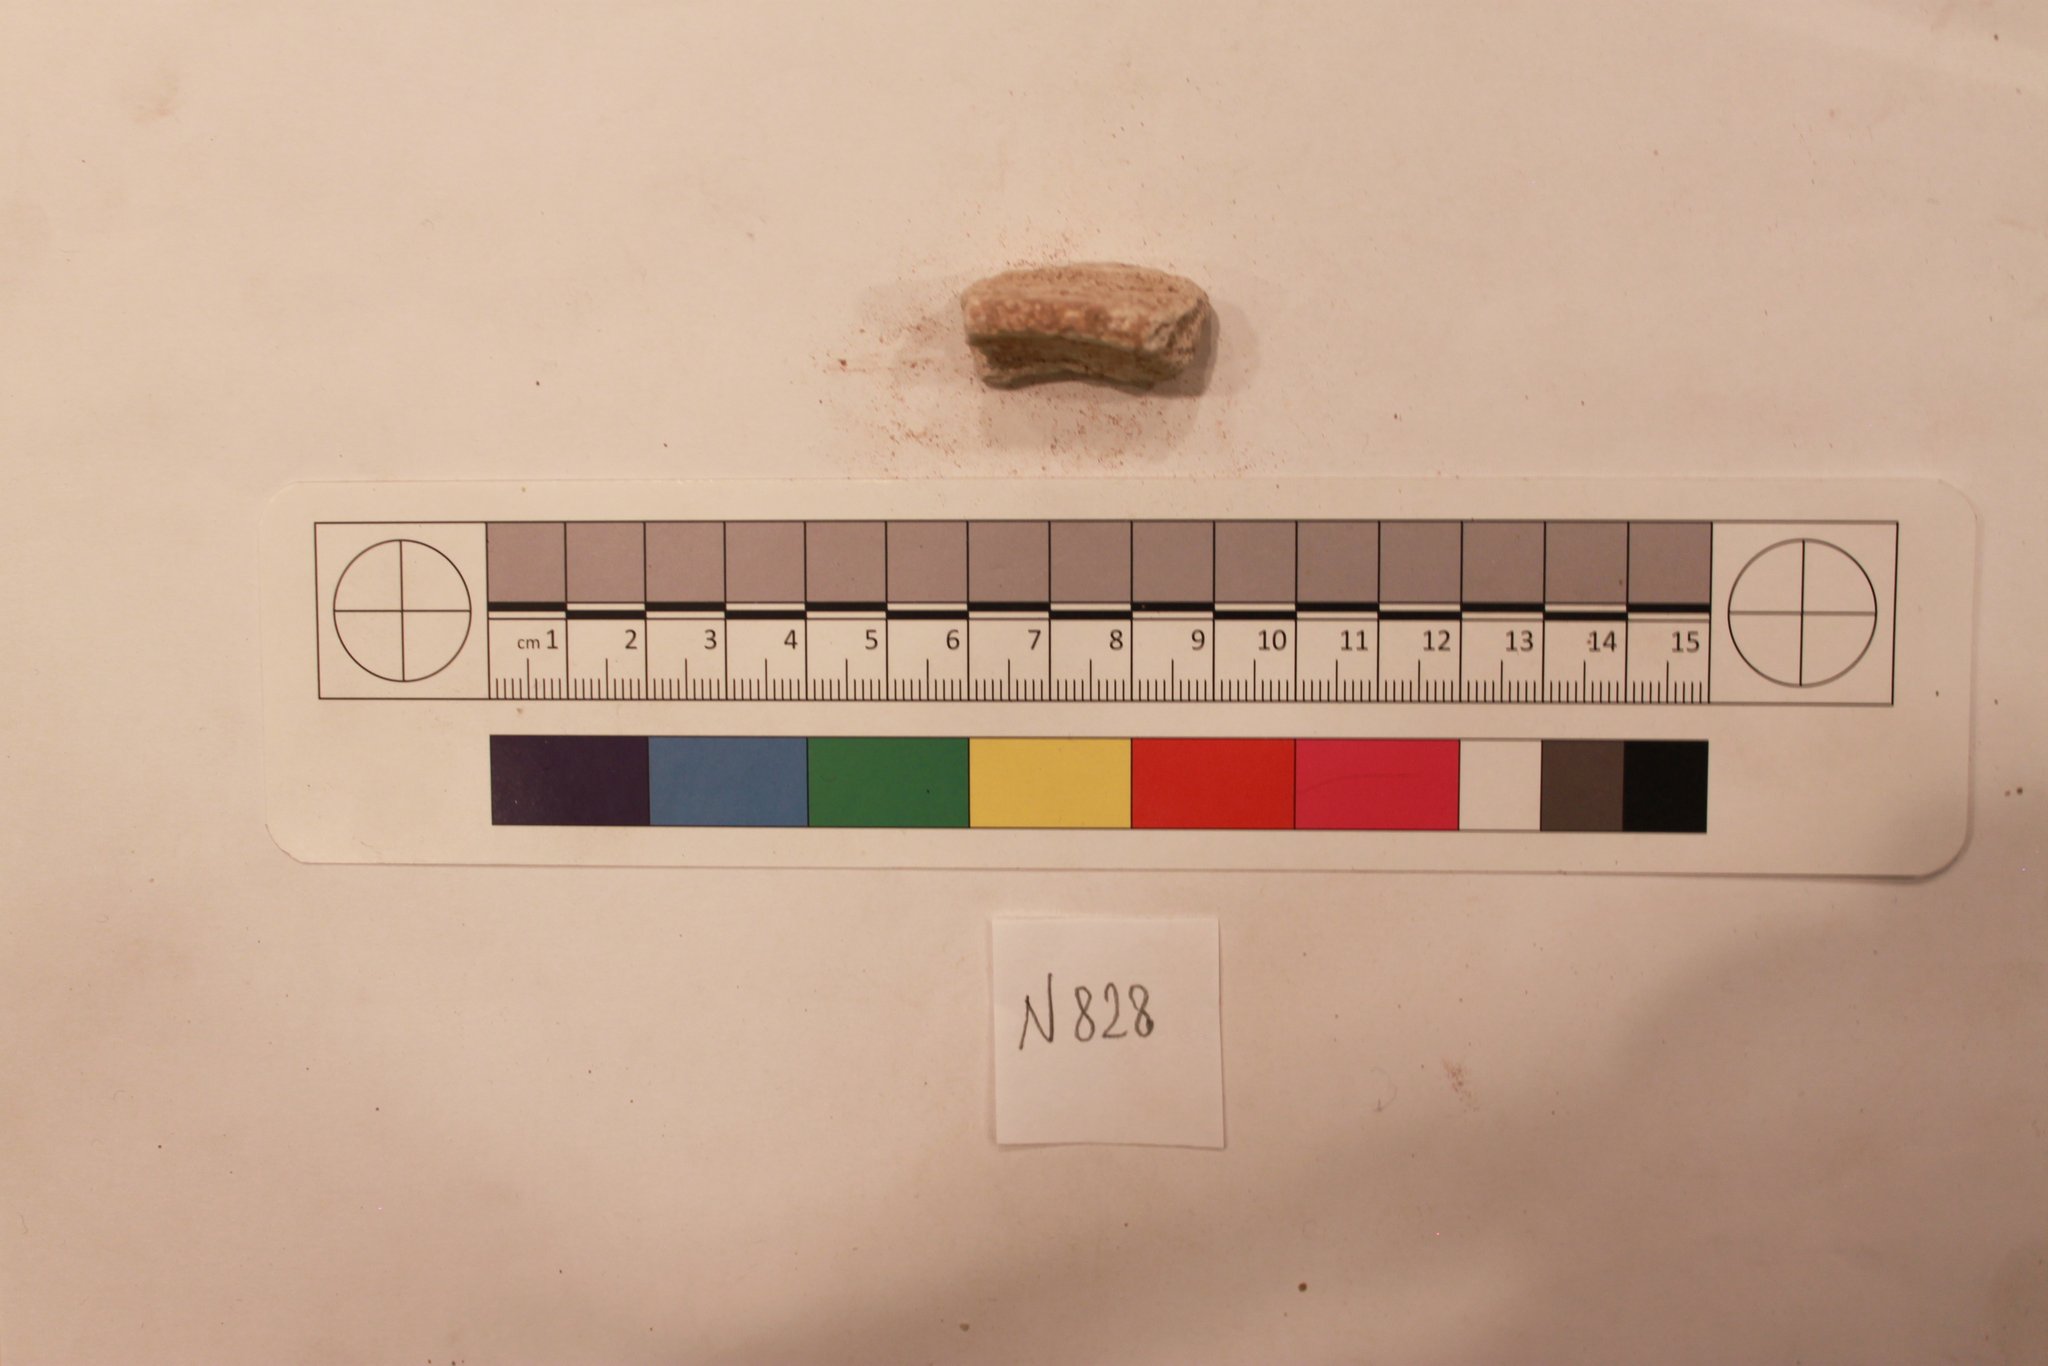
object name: fragment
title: Stucco Fragment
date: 701-1200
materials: plaster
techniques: carving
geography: iran